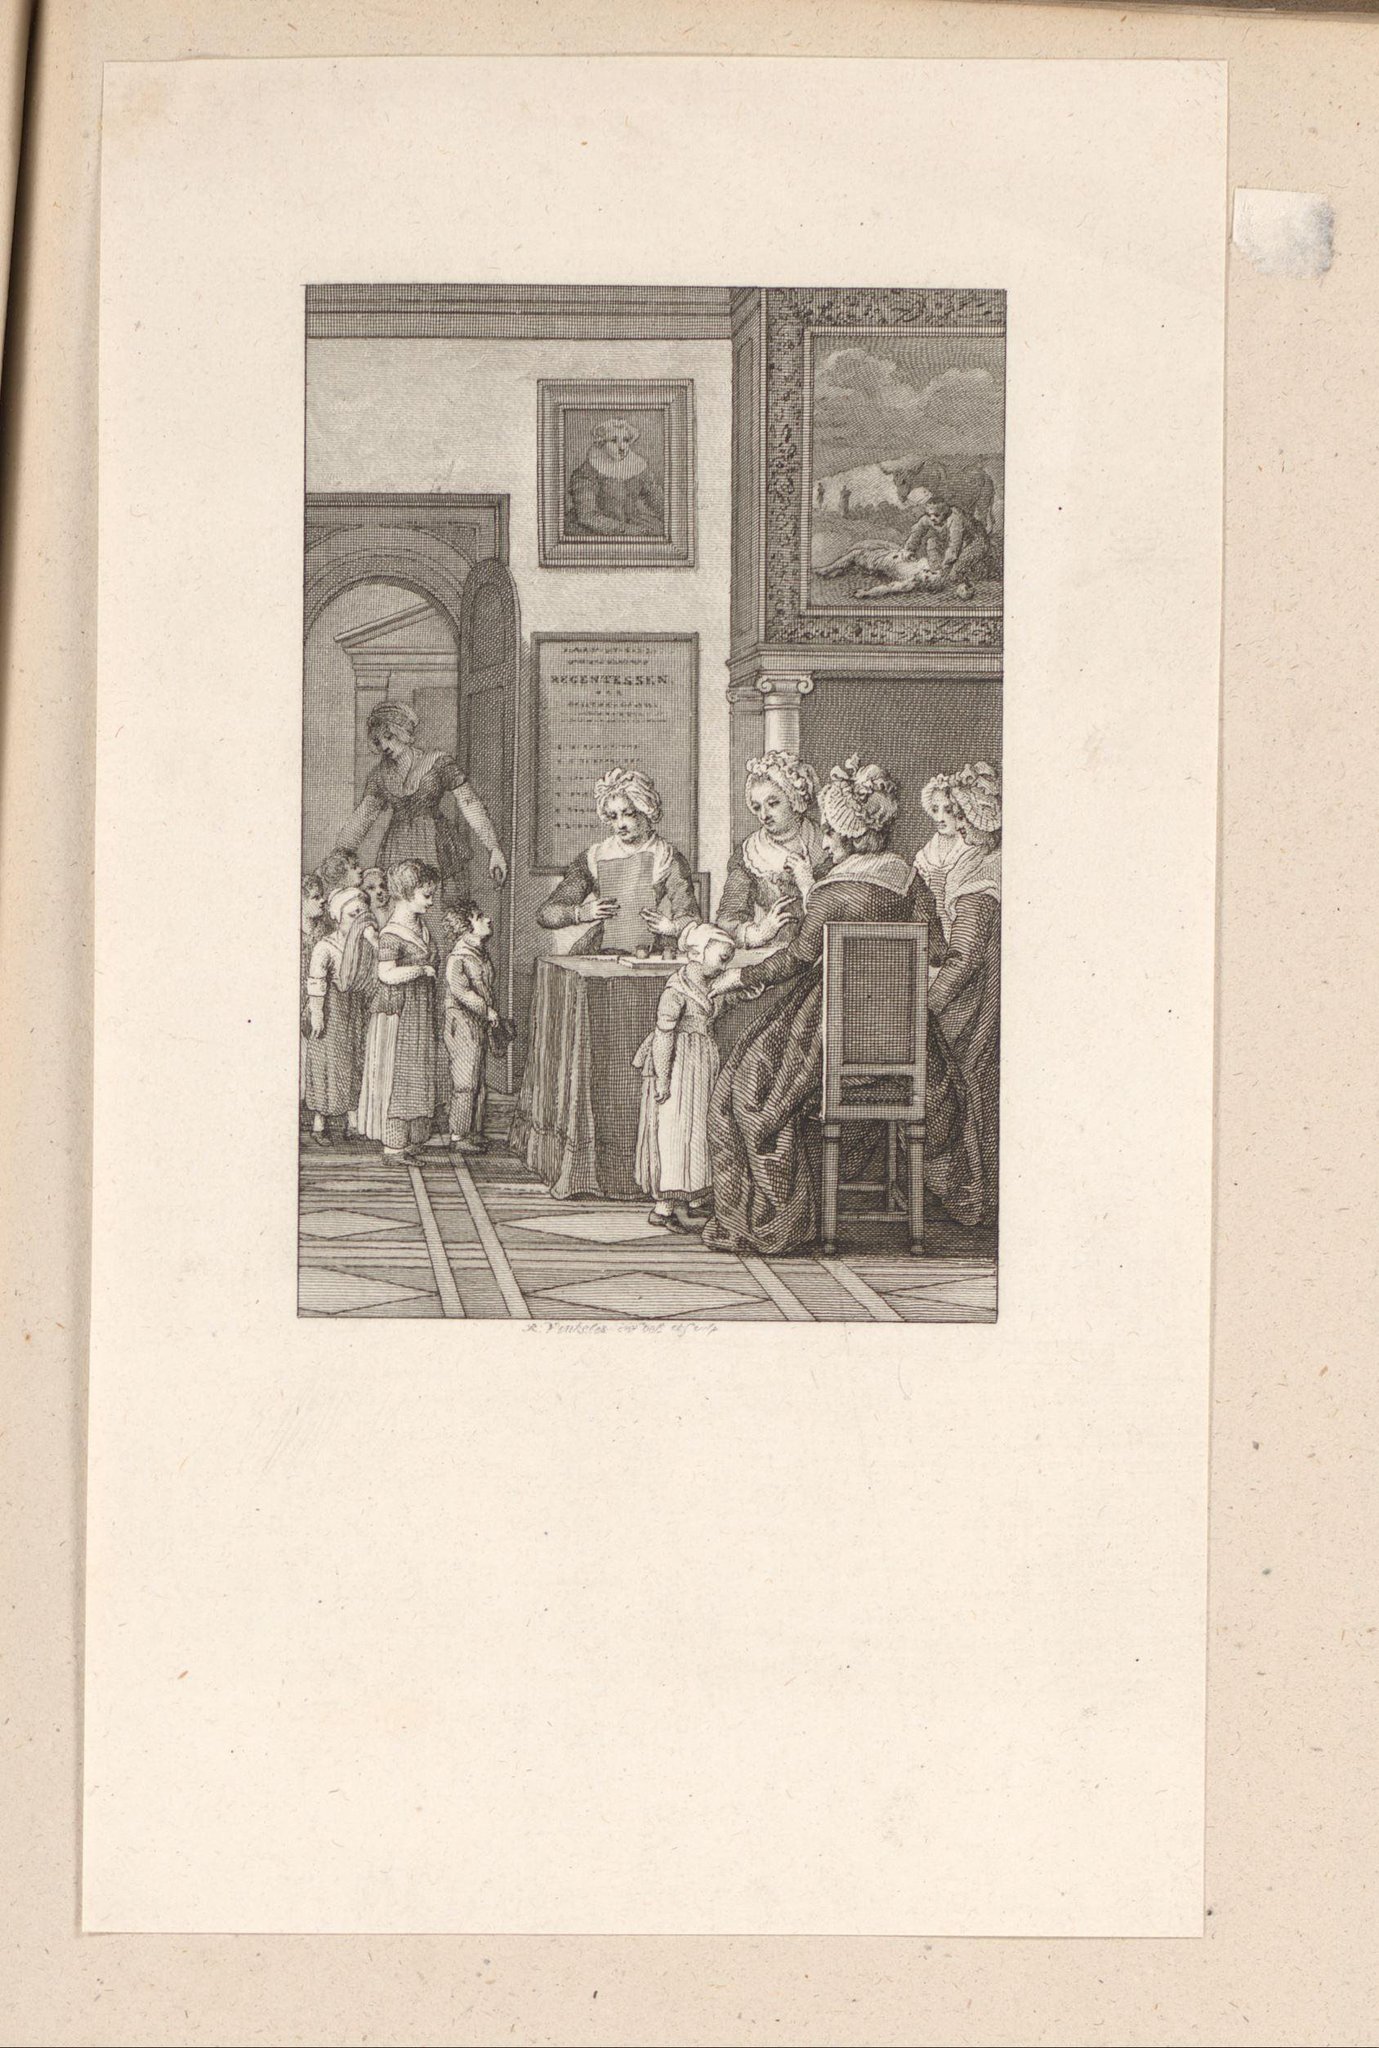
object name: album leaf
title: Vijf regentessen aan een tafel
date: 1809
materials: paper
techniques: engraving, etching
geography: haarlem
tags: old woman, picture, painting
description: Een groep kinderen meldt zich bij vijf oudere dames die aan een tafel zitten. Eén van de kinderen geeft een kus op de hand van een dame. In het vertrek hangen twee schilderijen. De prent maakt deel uit van een album.